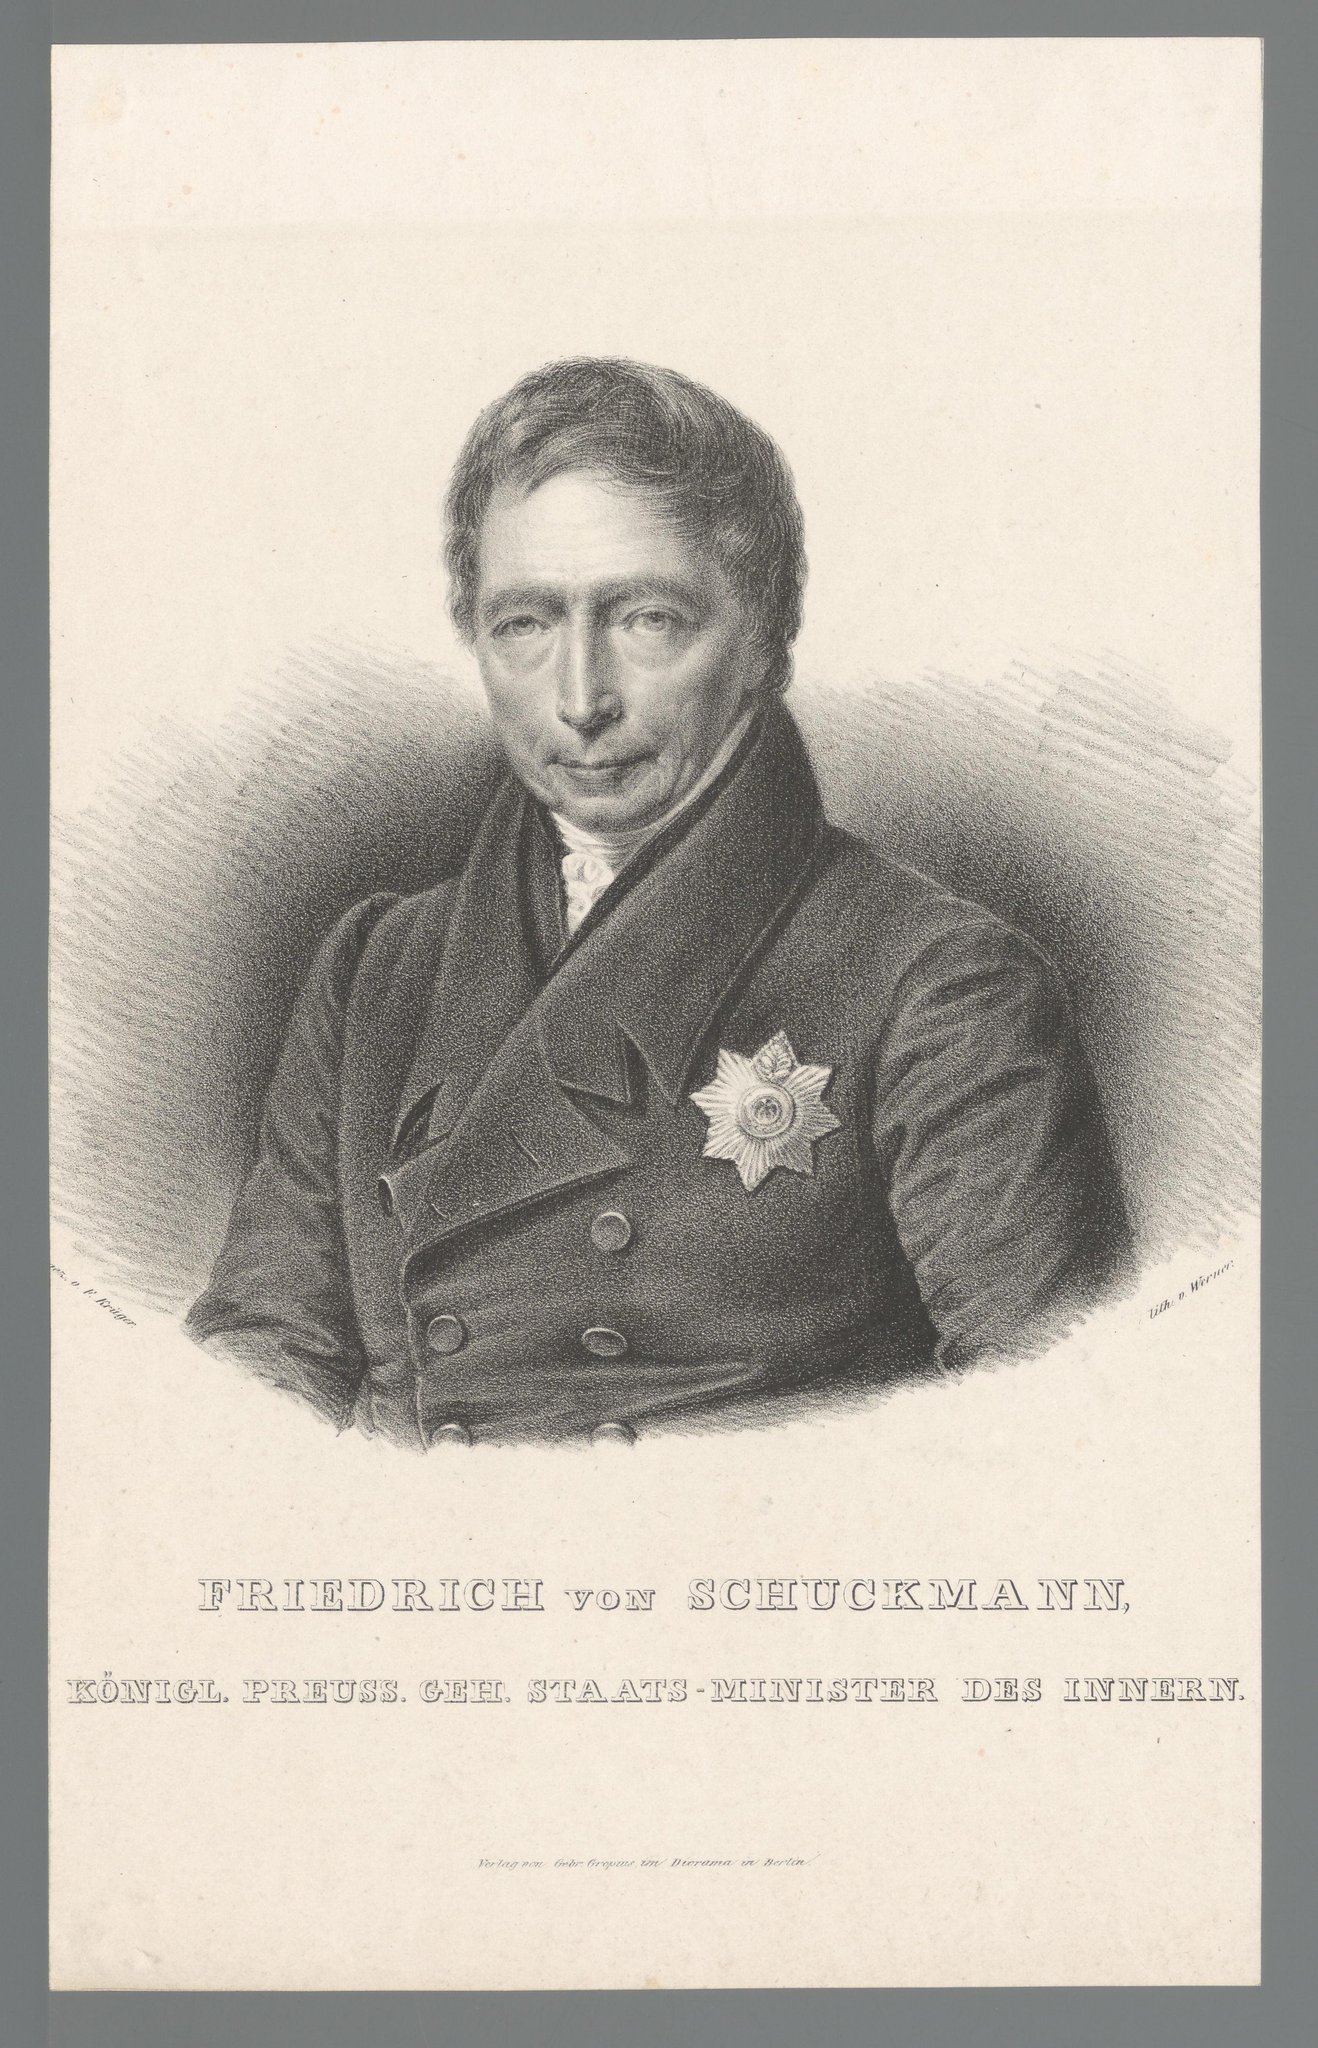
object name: print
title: Friedrich von Schuckmann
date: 1807-1857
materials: paper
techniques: lithograph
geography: berlin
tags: berlin, politician, historical persons, politician, e.g. party leader, law and jurisprudence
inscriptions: collector's mark: Lugt 2228